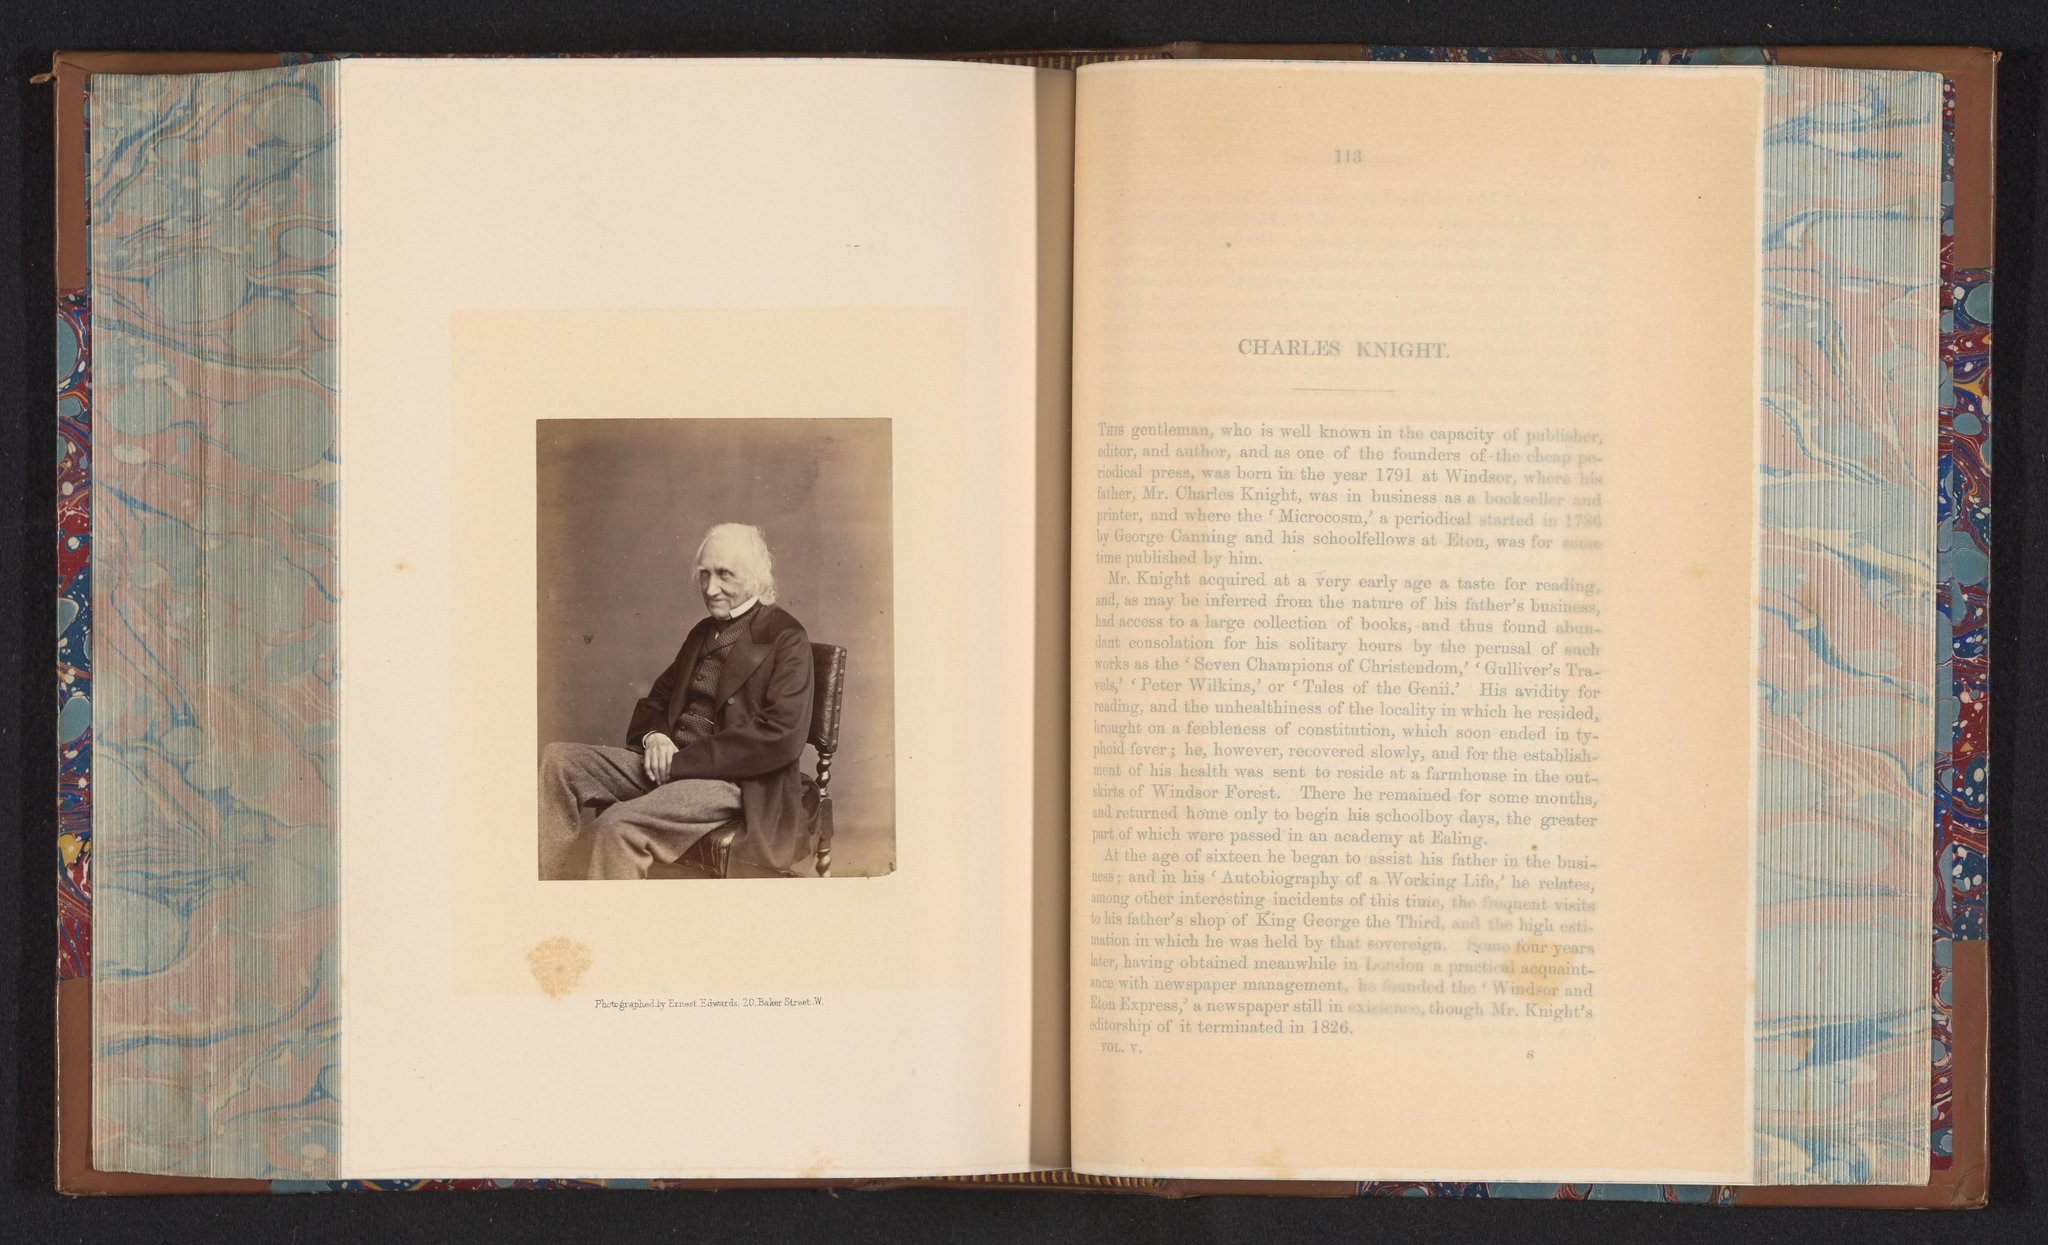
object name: photograph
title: Portret van Charles Knight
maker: ernest edwards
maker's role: fotograaf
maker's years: 1837-1903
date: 1856-1866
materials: photographic support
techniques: albumen print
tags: printer, publisher, charles knight (1791-1873), publishing, publisher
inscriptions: name: ‘Photographed by Ernest Edwards, 20, Baker Street. W.’